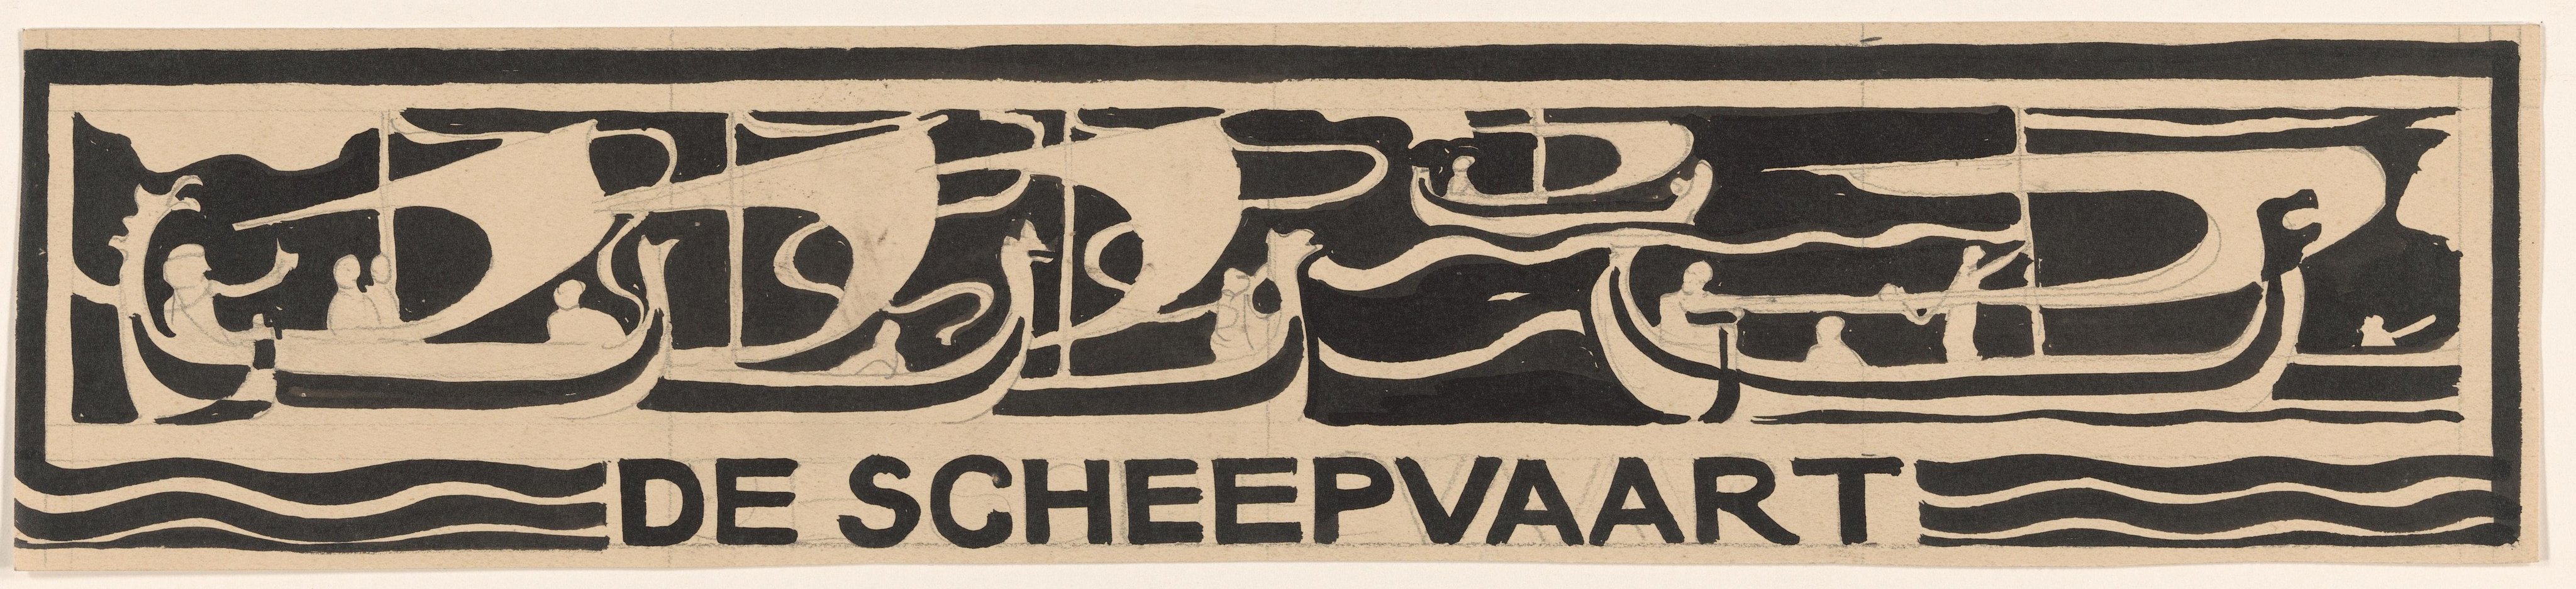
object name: drawing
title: Ontwerp voor vignet in het gedenkboek voor koningin Wilhelmina uit 1923: De Scheepvaart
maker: carel adolph lion cachet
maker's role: draughtsman, print maker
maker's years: 1864-1945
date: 1874-1945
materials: paper, pencil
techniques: brush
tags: 'navigatione' (ripa)